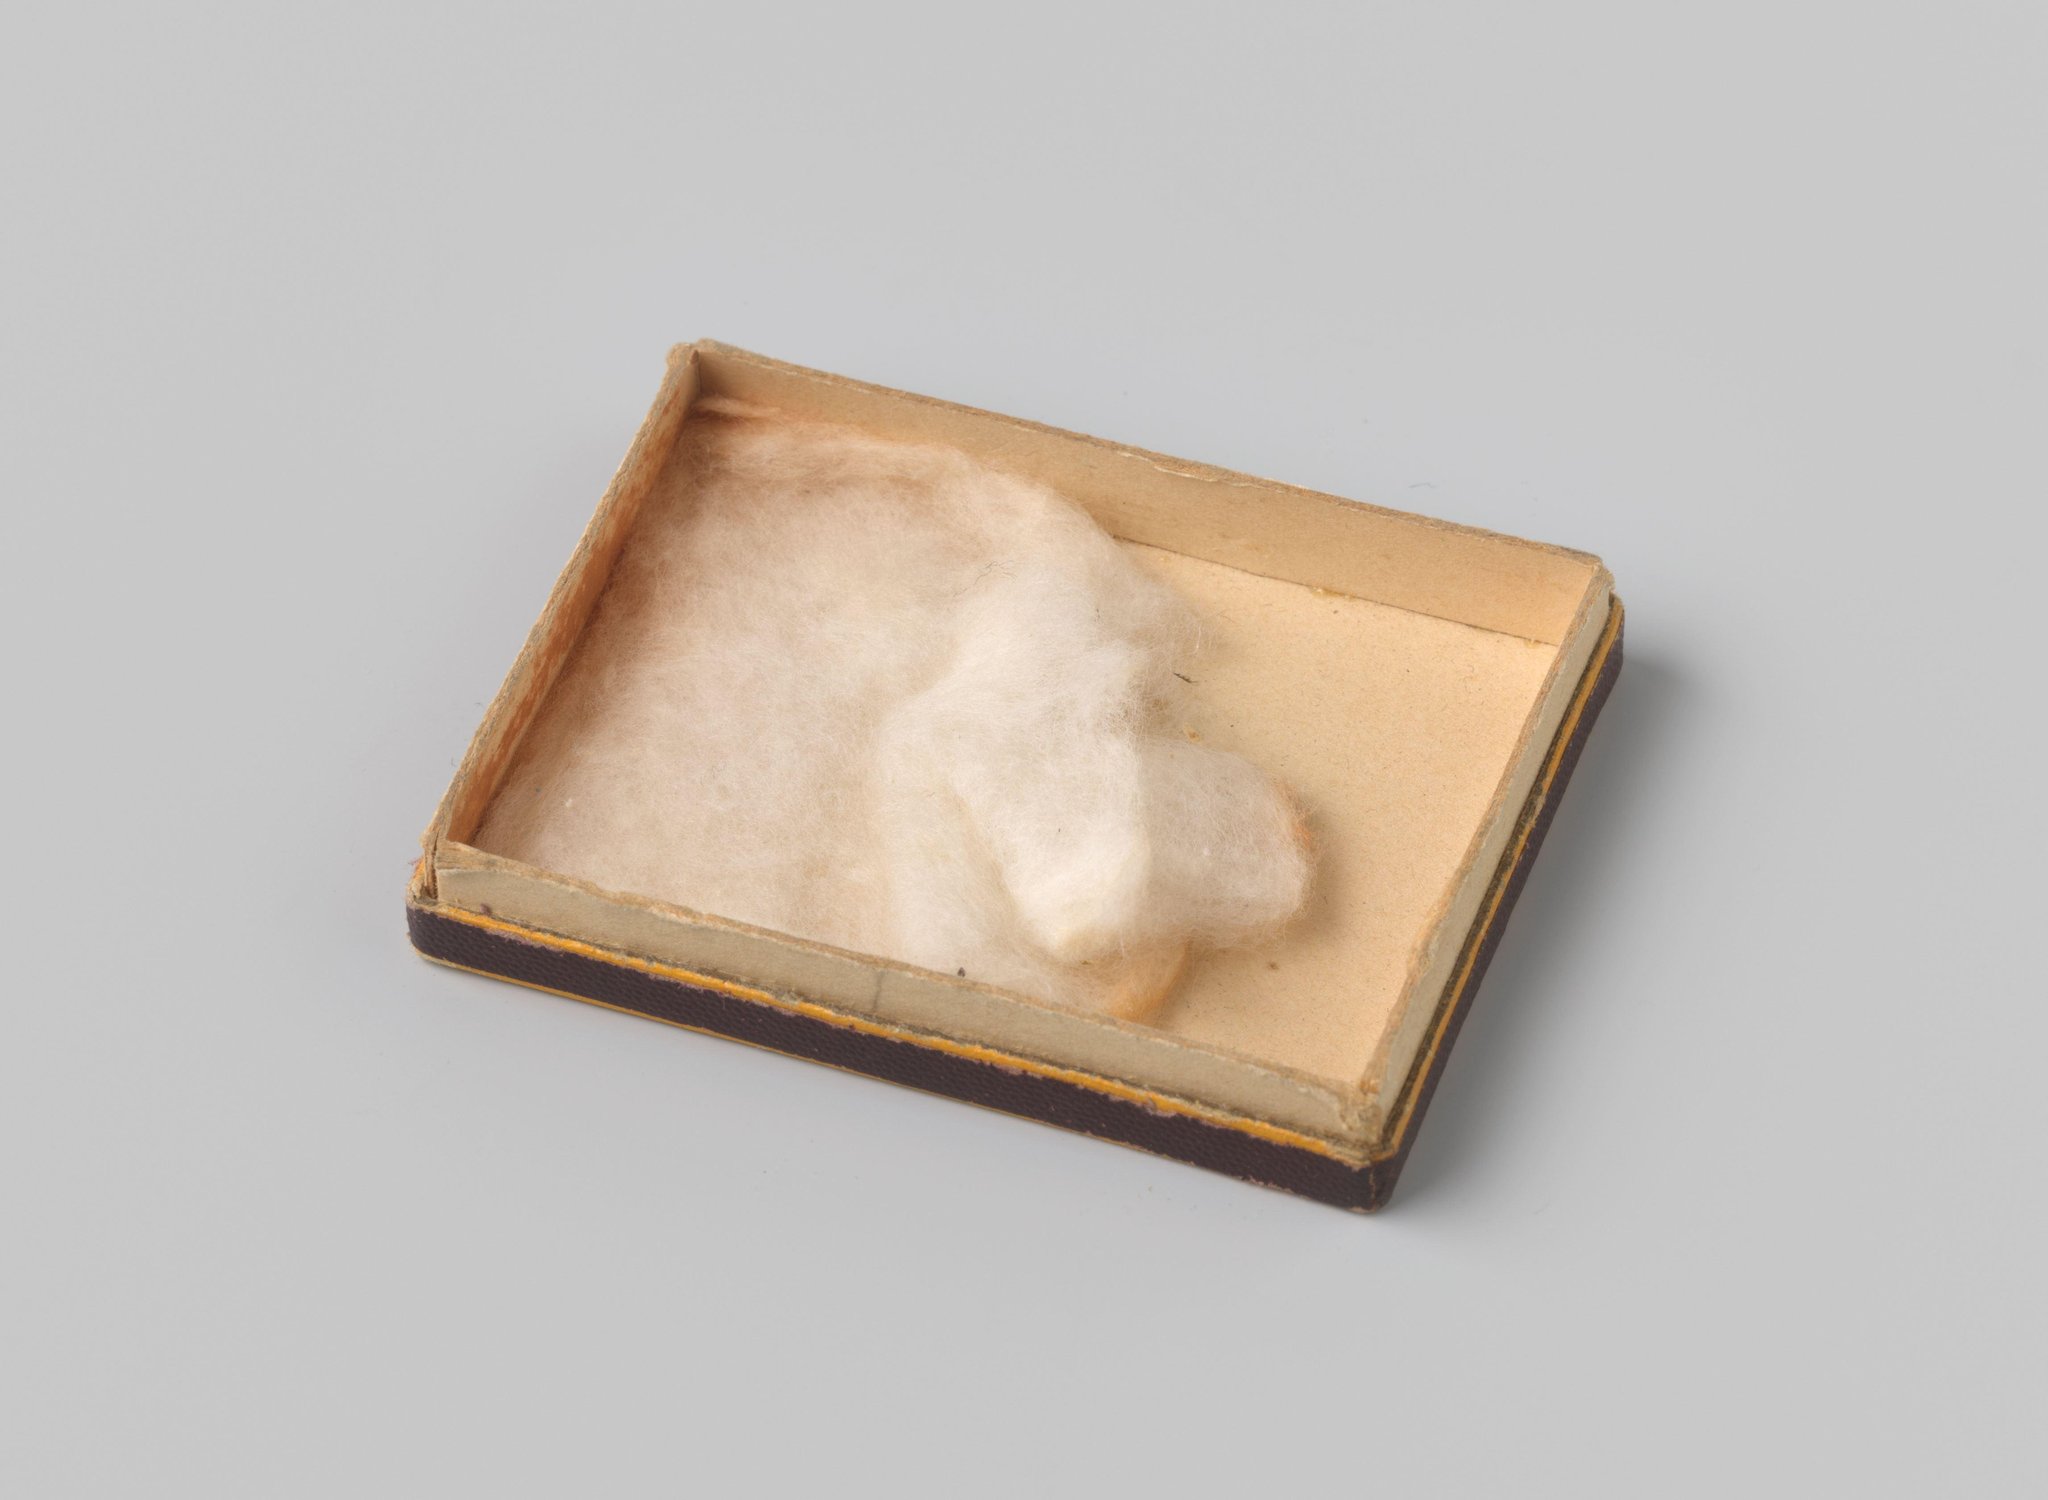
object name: box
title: Doos behorend bij een bronzen penning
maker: fernand dubois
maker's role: medailleur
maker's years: 1861-1911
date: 1903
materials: cardboard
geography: brussels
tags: belgium